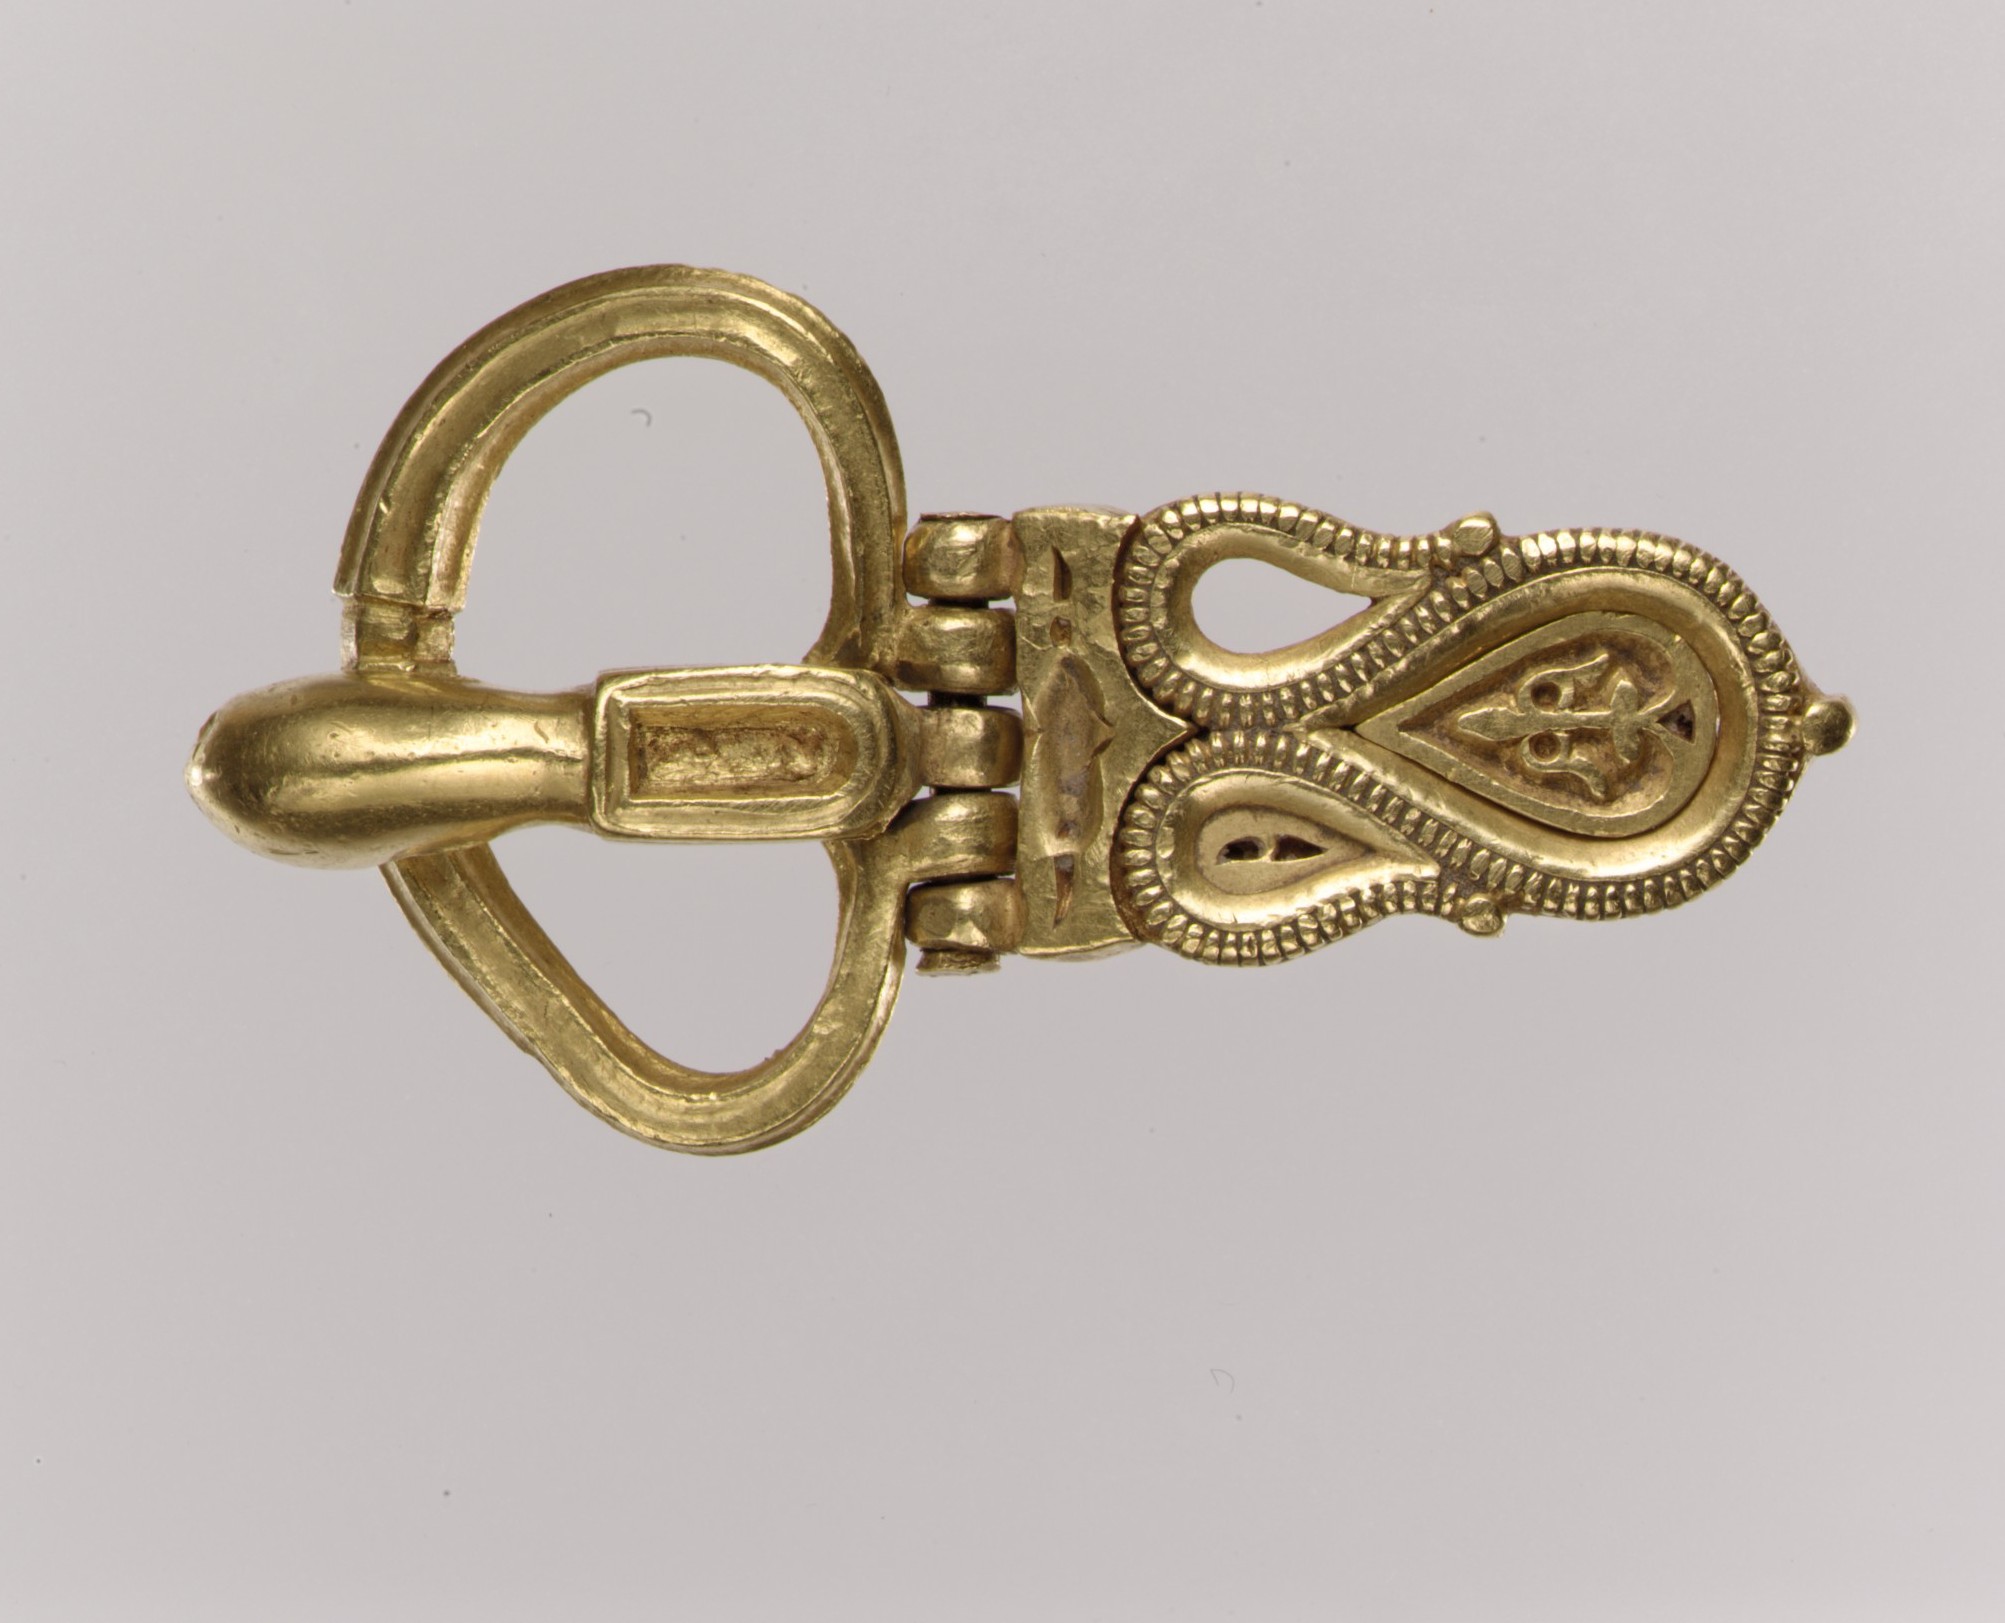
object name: buckle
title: Gold Buckle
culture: byzantine or langobardic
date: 501-700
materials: gold, metal